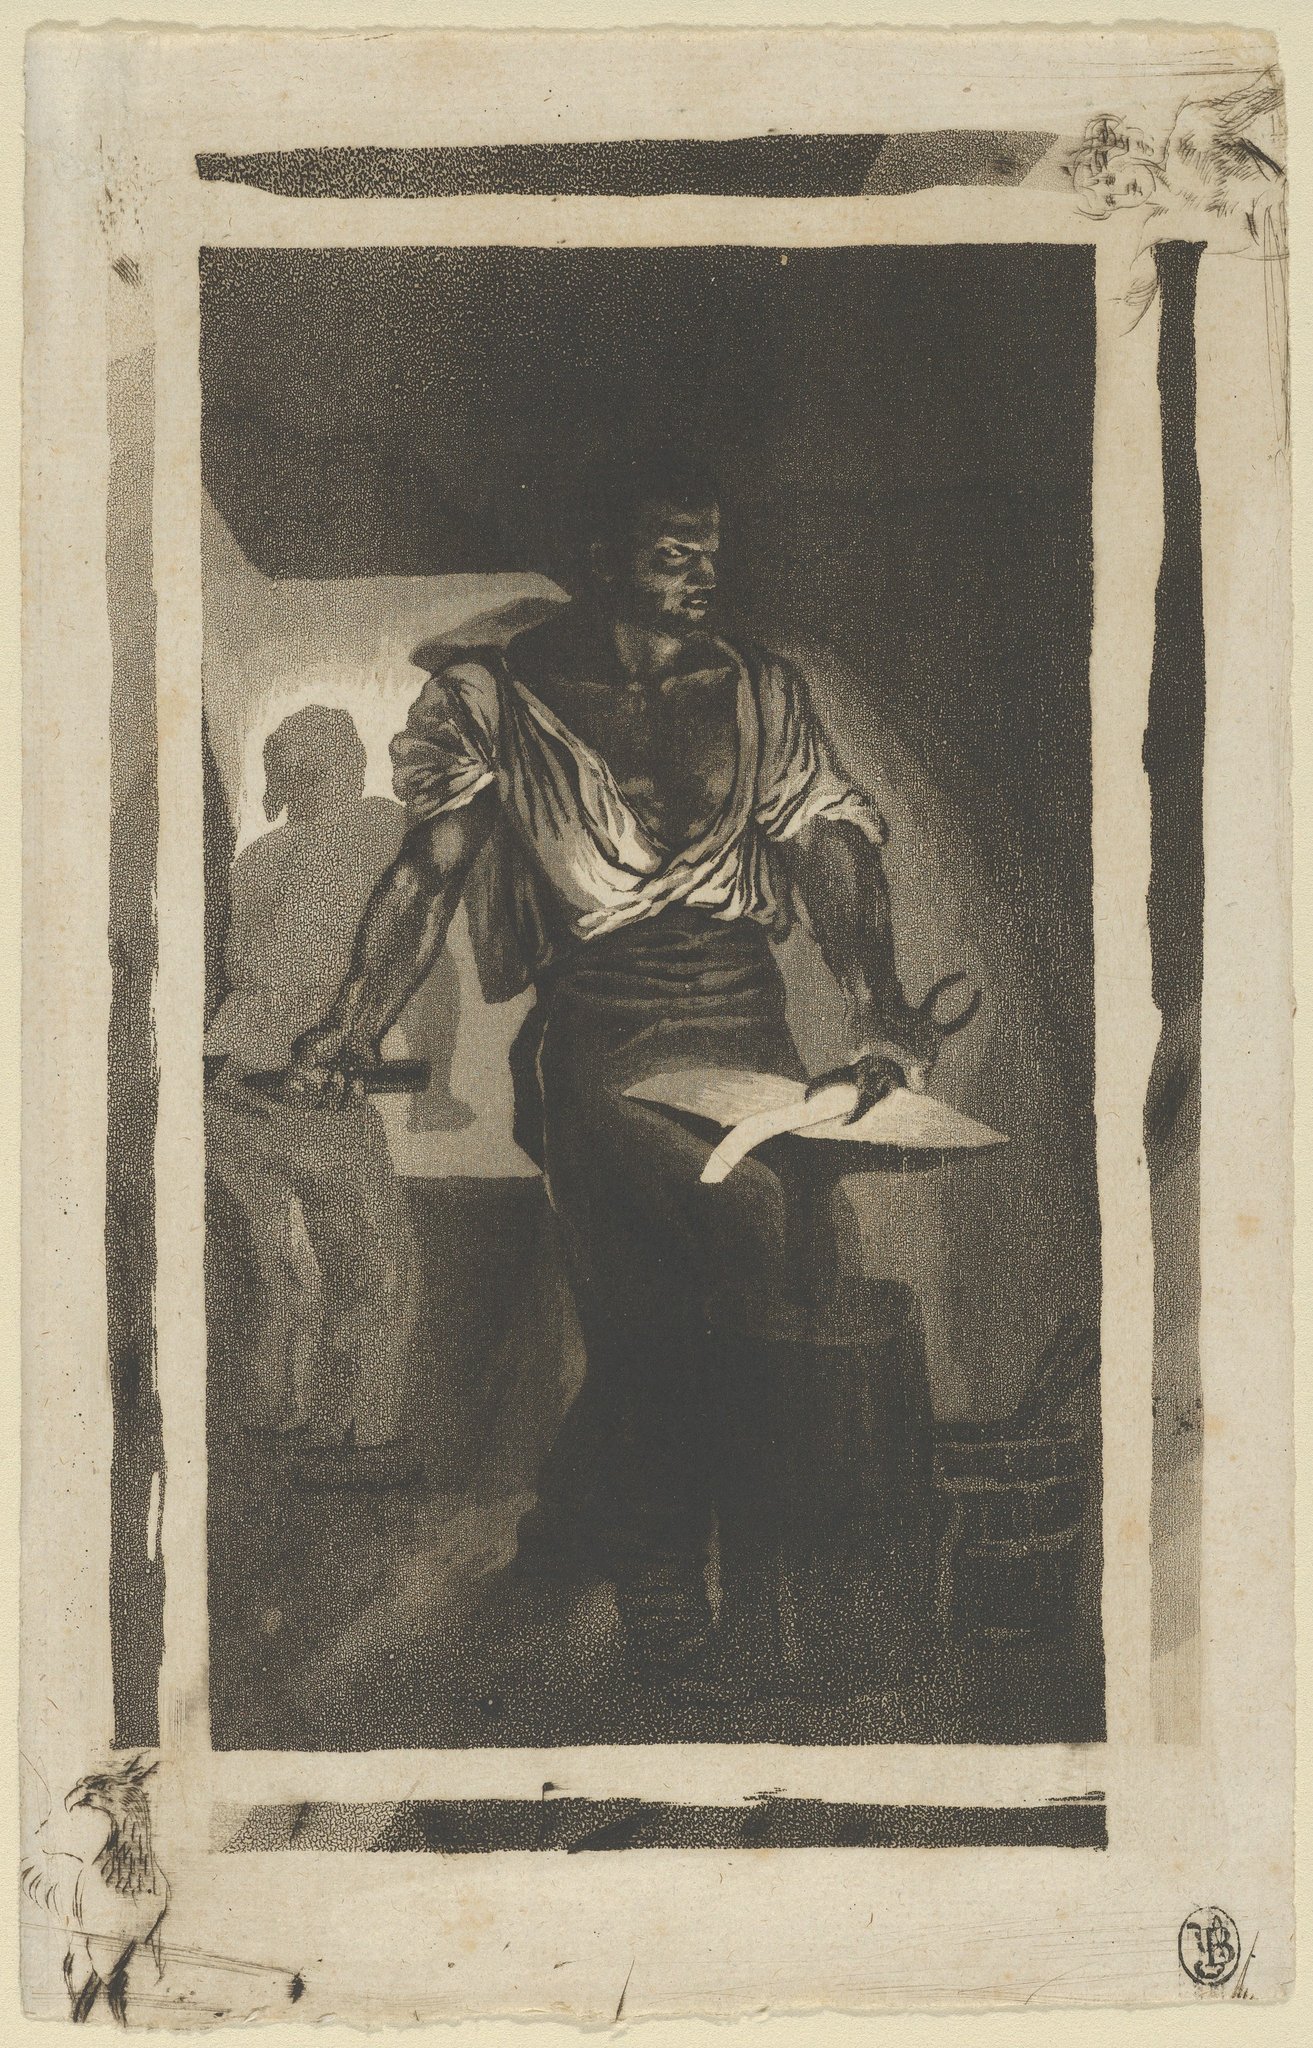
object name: print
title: A Blacksmith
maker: eugène delacroix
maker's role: artist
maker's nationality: french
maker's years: 1798-1863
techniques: aquatint, drypoint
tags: men,working,blacksmiths